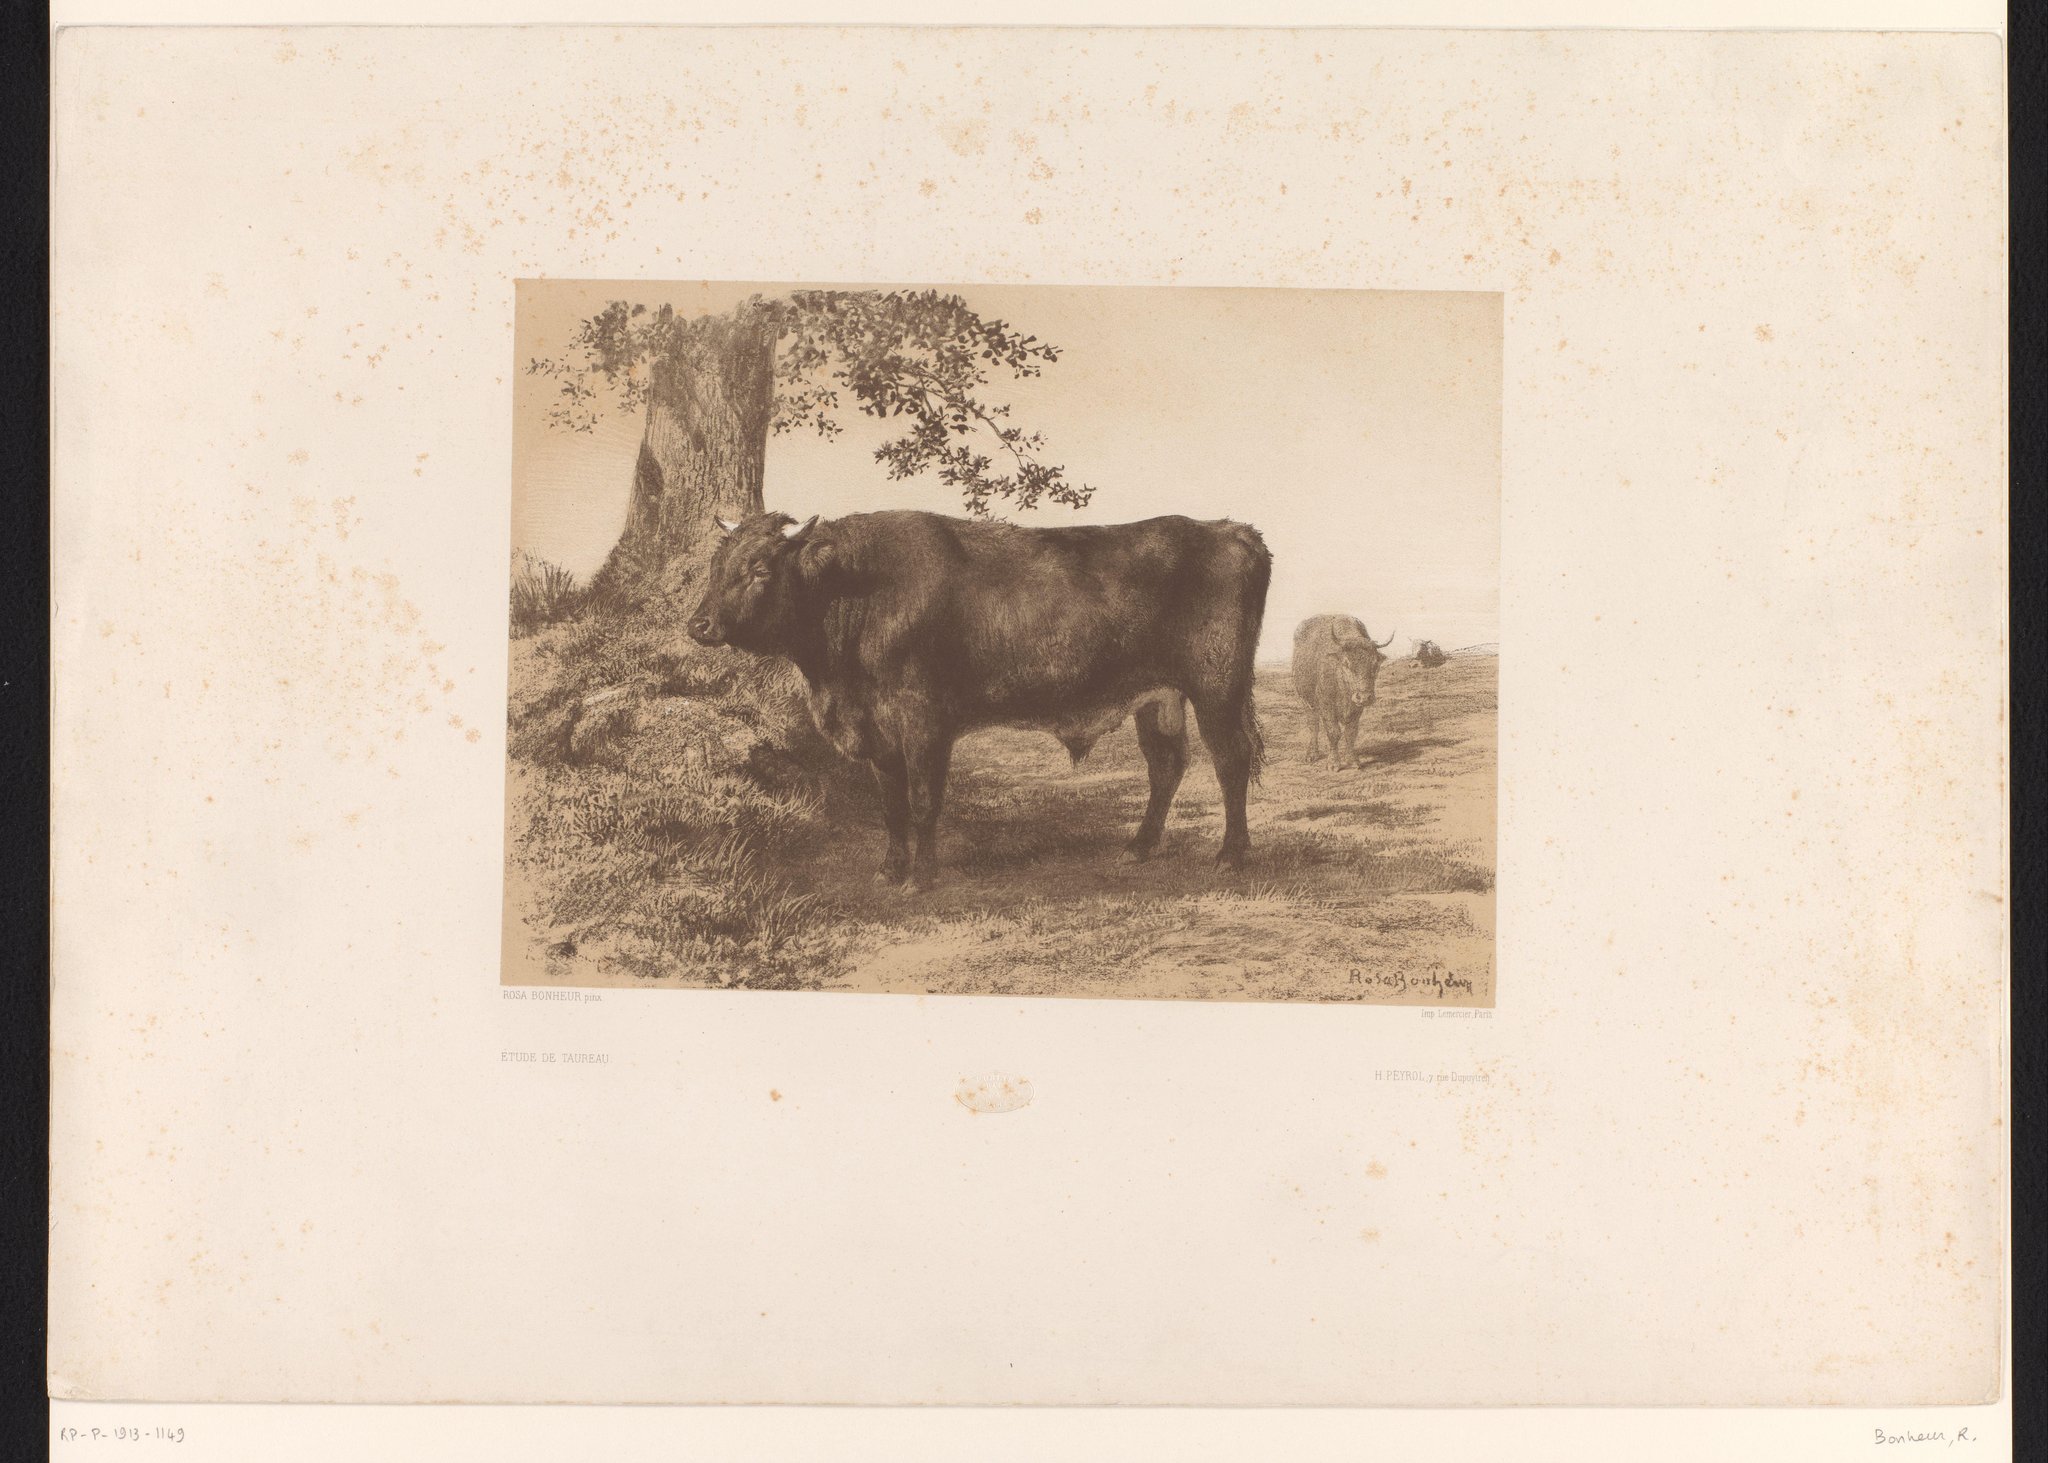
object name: print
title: Spaanse stier bij een boom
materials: paper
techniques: tone lithography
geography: paris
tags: bull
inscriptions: check stamp: Lugt 4777, collector's mark: Lugt 2228a